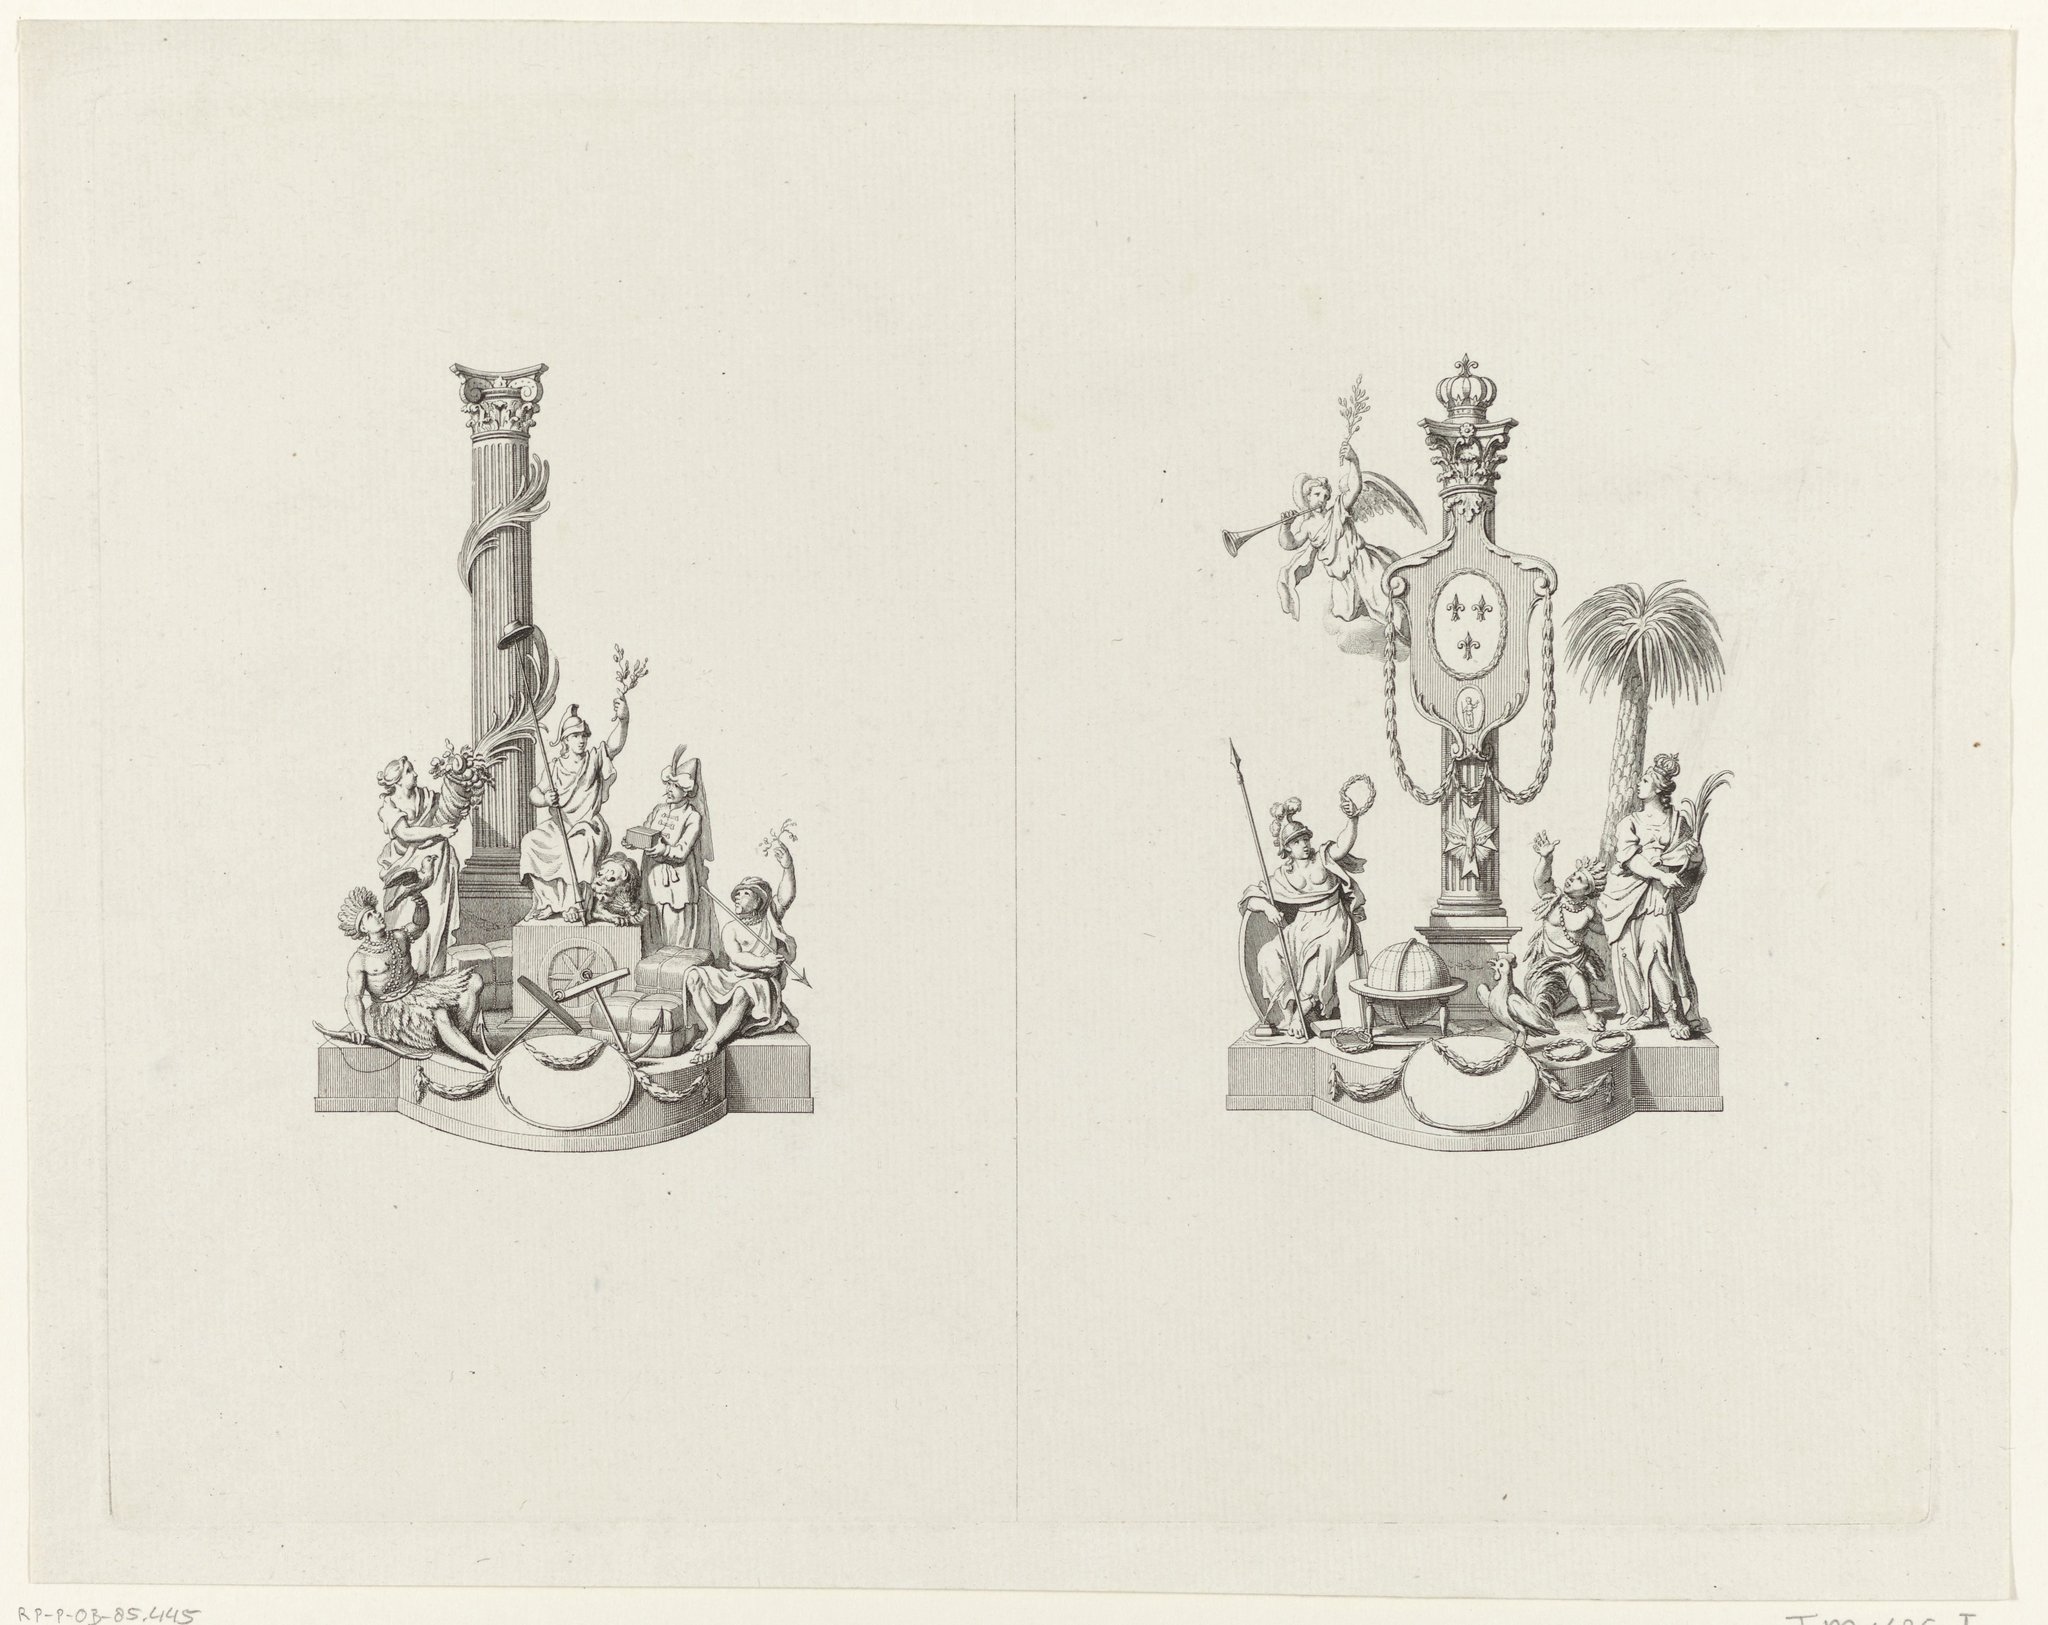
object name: print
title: Twee allegorische tafelversieringen, 1786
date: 1786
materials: paper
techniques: engraving, etching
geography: northern netherlands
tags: festivities on events of national importance (+ eating and drinking ~ festive activities), centre-piece, epergne, 'surtout', 'milieu-de-table', alliance with france (1785)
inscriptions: collector's mark: Lugt 2228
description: Blad met twee allegorische tafelversieringen (milieu de table) gebruikt bij de feestelijke maaltijd gehouden op 27 januari 1786 te Amsterdam om de Alliantie met Frankrijk te vieren. Links "Nederlands Groei en Bloei": de Nederlandse Maagd gezeten voor een zuil omringd door allegorische figuren. Rechts "Vrankrijks Voorspoed": een zuil met het Franse wapen omringd door allegorische figuren.